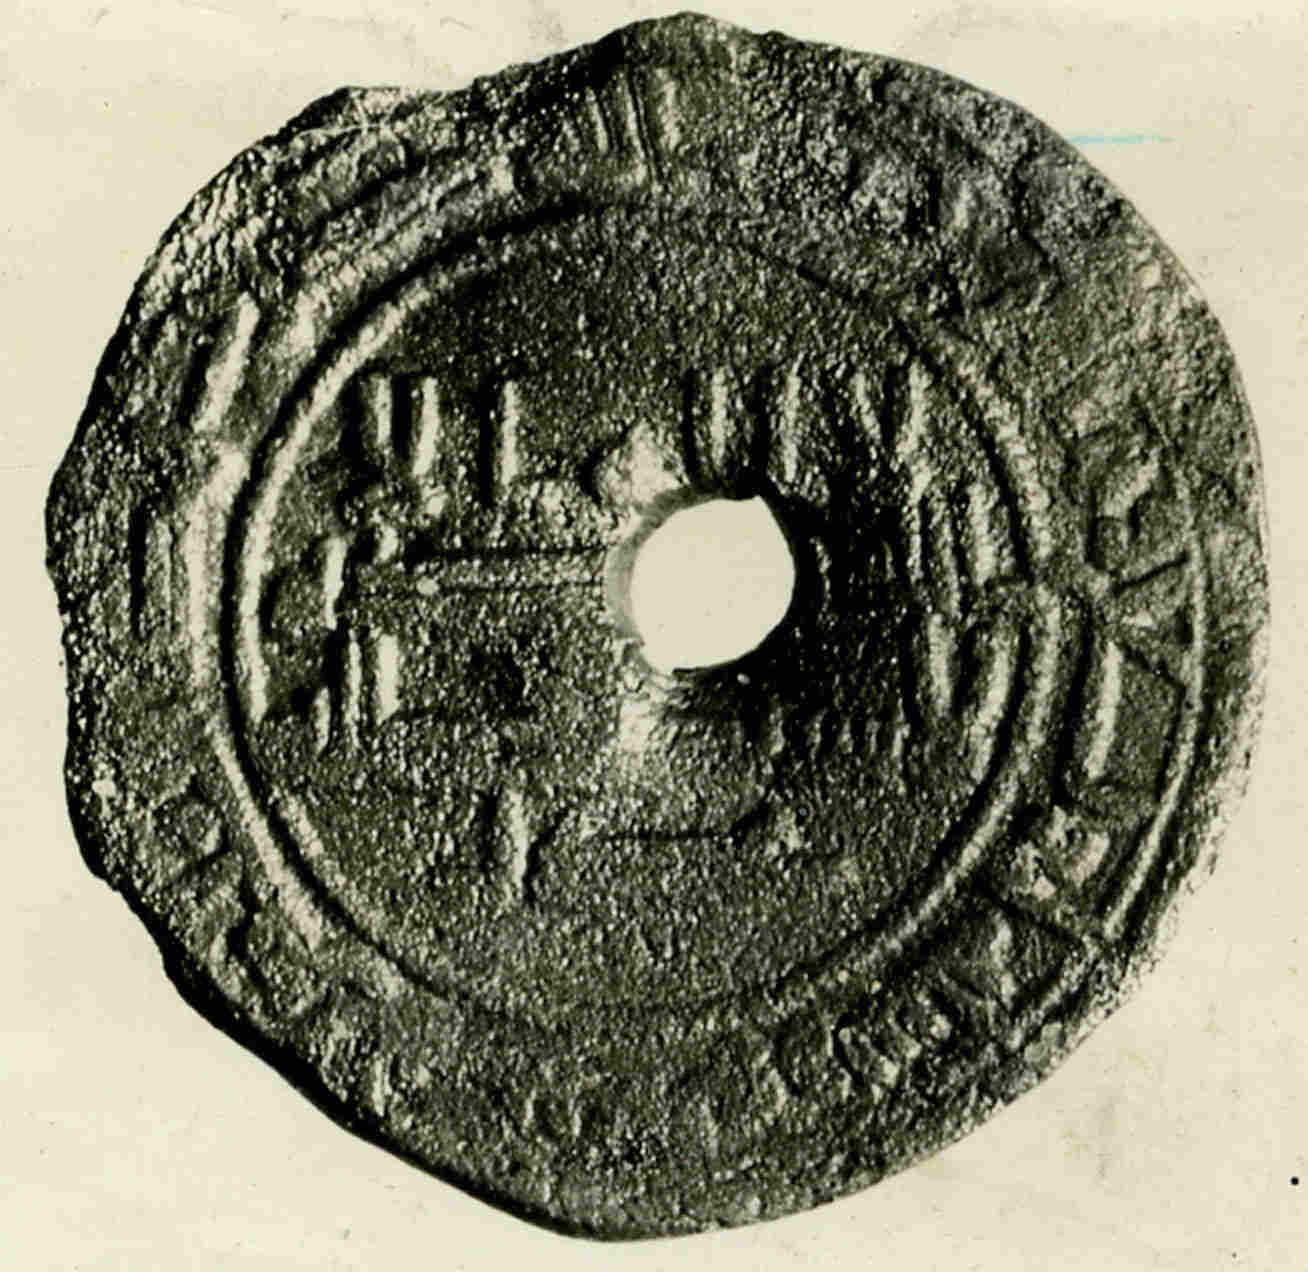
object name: coin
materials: copper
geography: iran